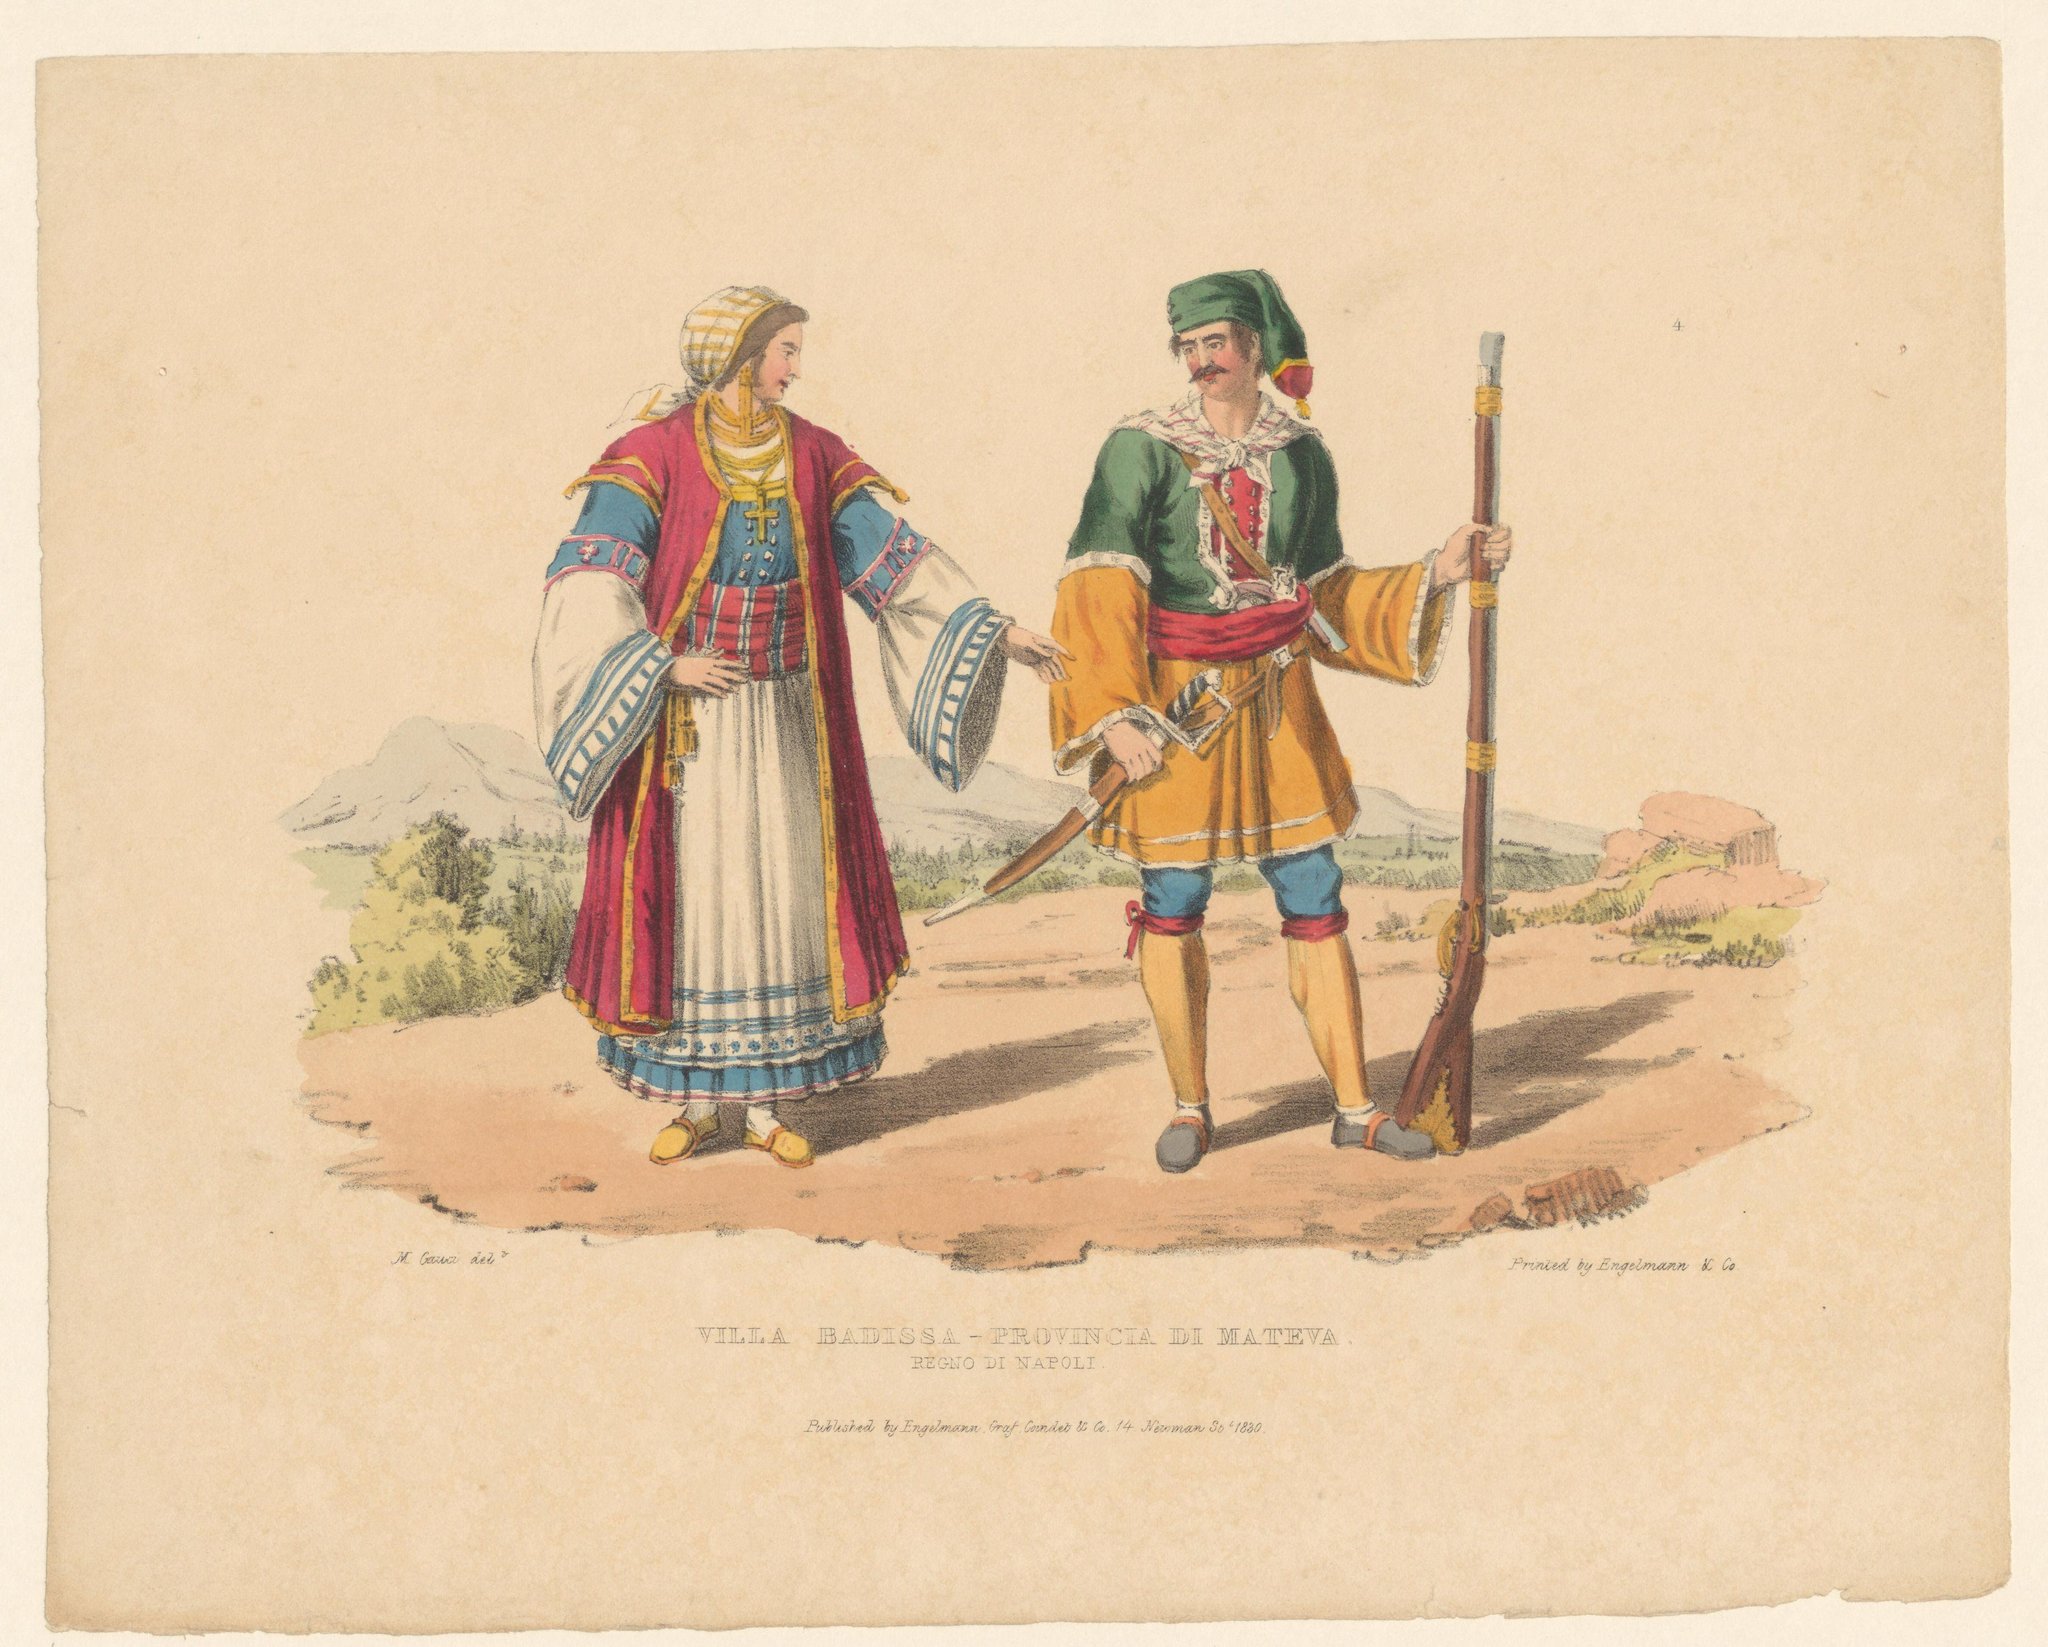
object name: print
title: The Neapolitan Costume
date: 1830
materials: paper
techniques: hand coloring, lithograph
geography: london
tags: adult woman, adult man, folk costume, regional costume, europeans (with name)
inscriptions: mark: ‘School voor de grafische vakken te Utrecht’, collector's mark: Lugt 2228